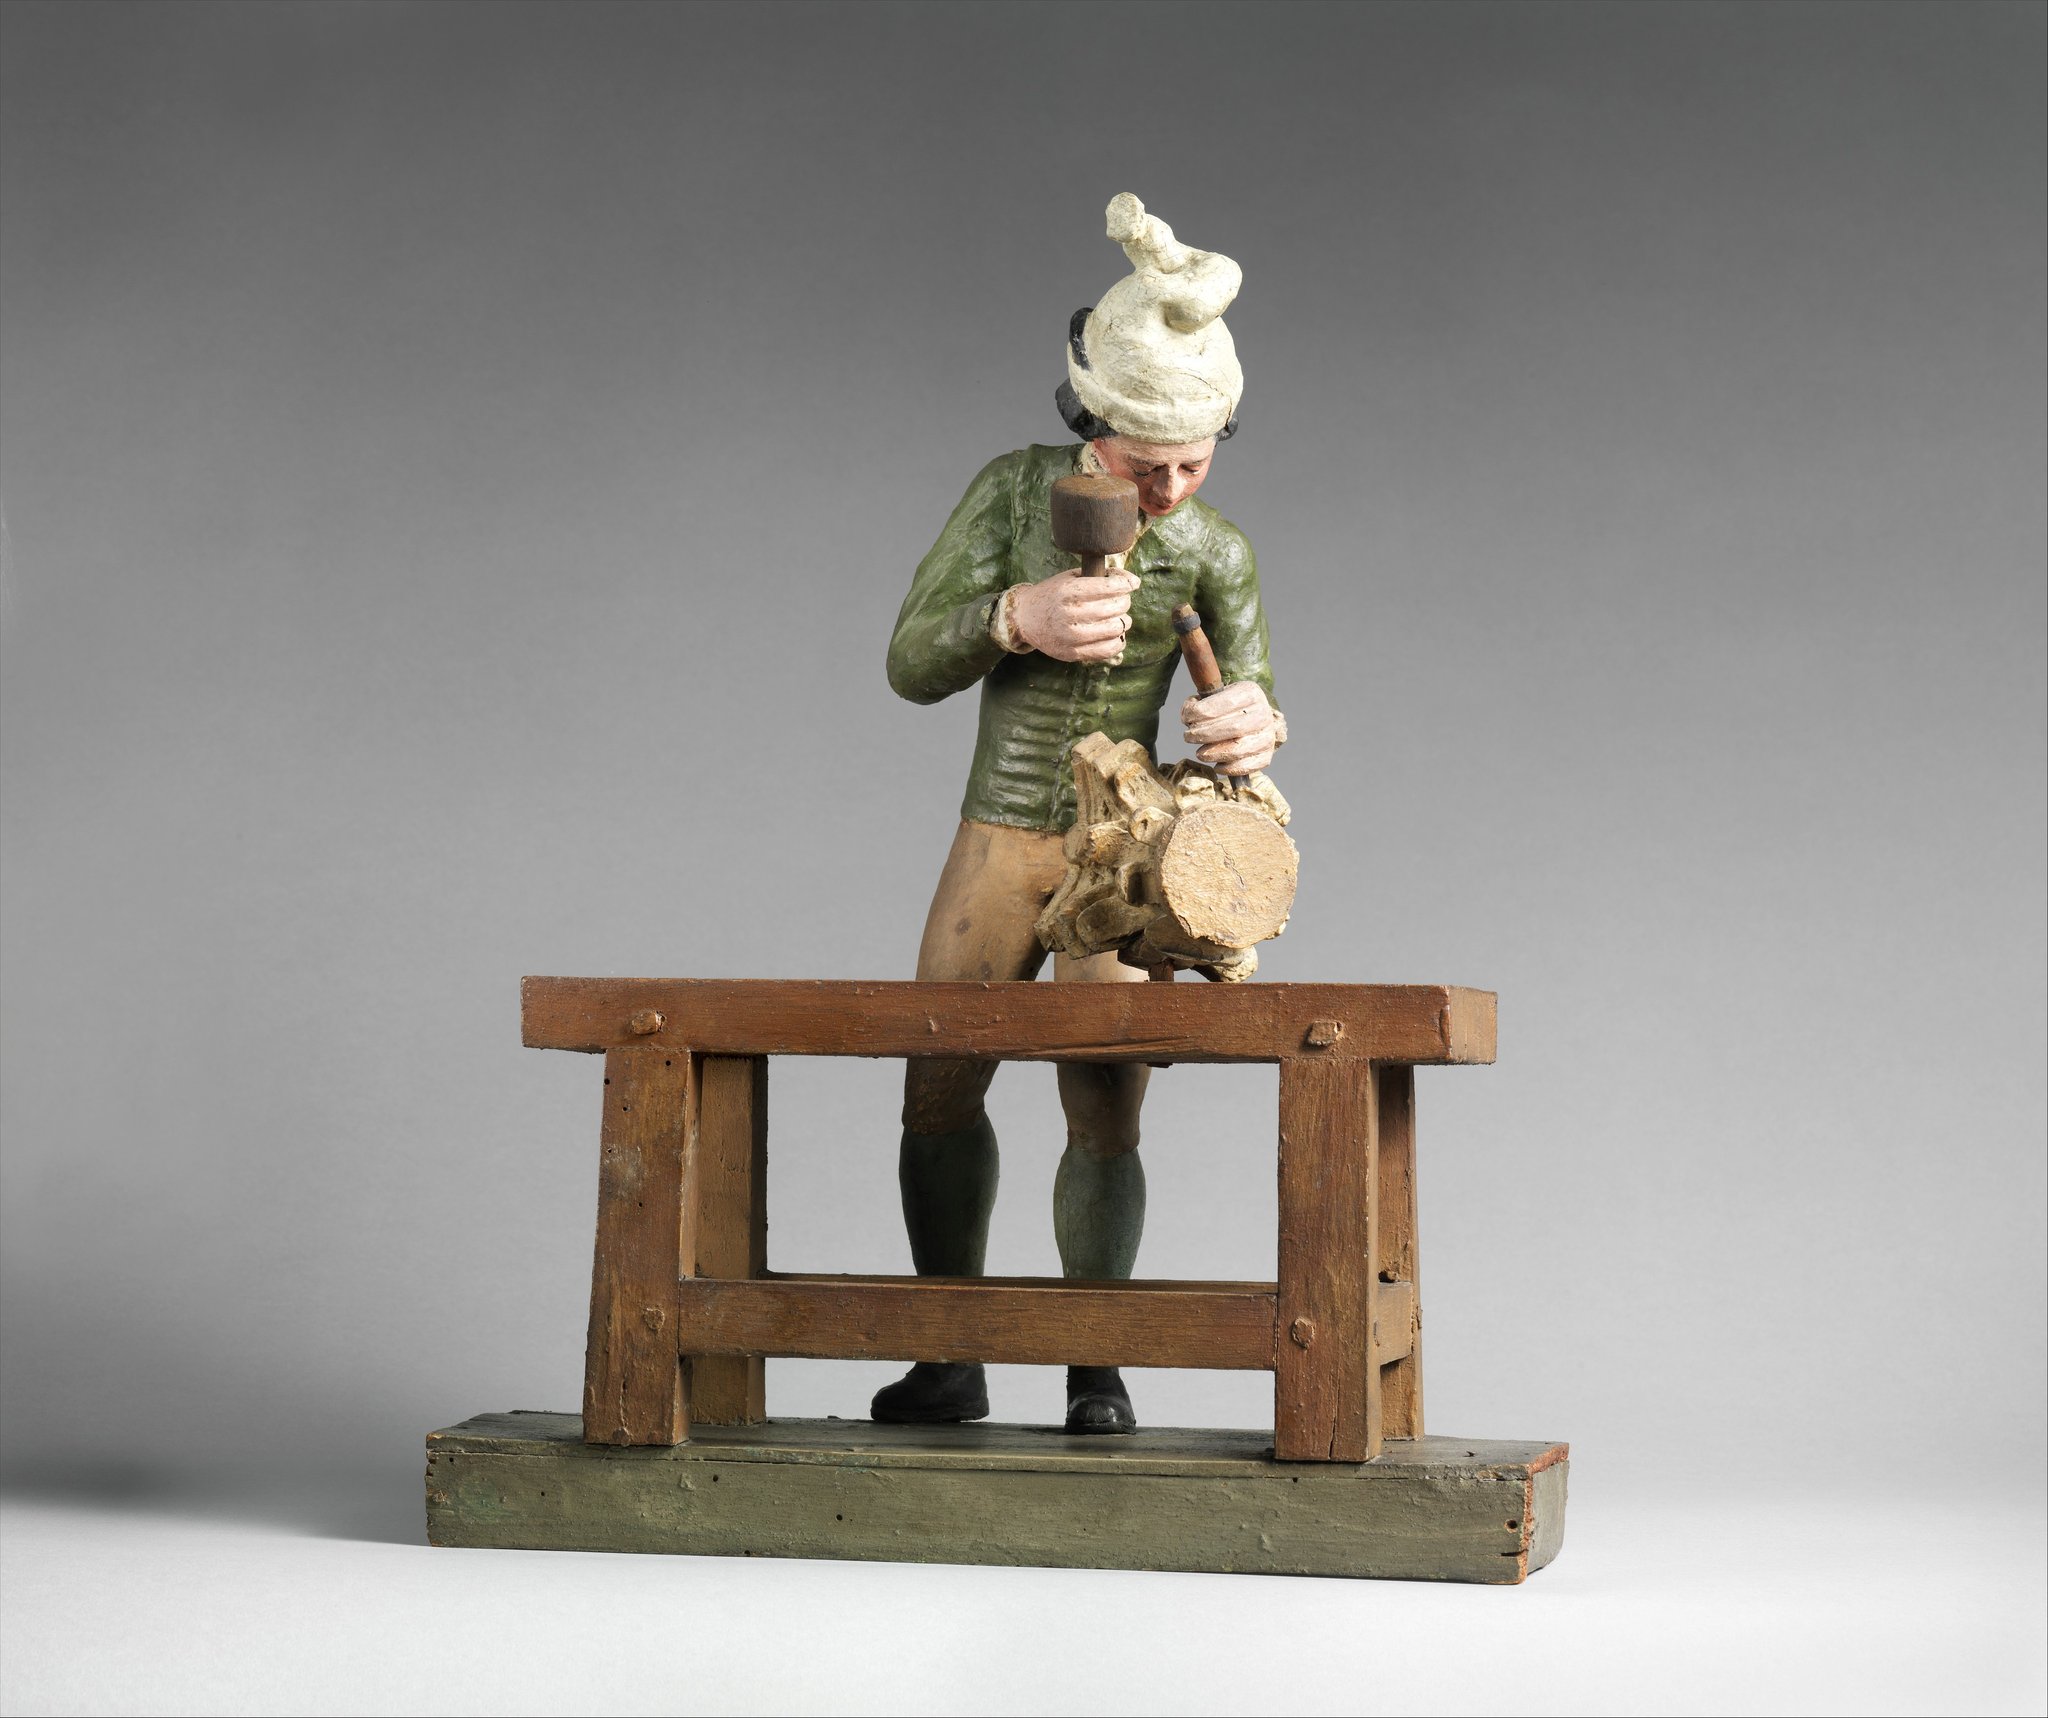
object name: statuette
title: Stone carver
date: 1701-1750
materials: wood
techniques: painting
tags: men,working